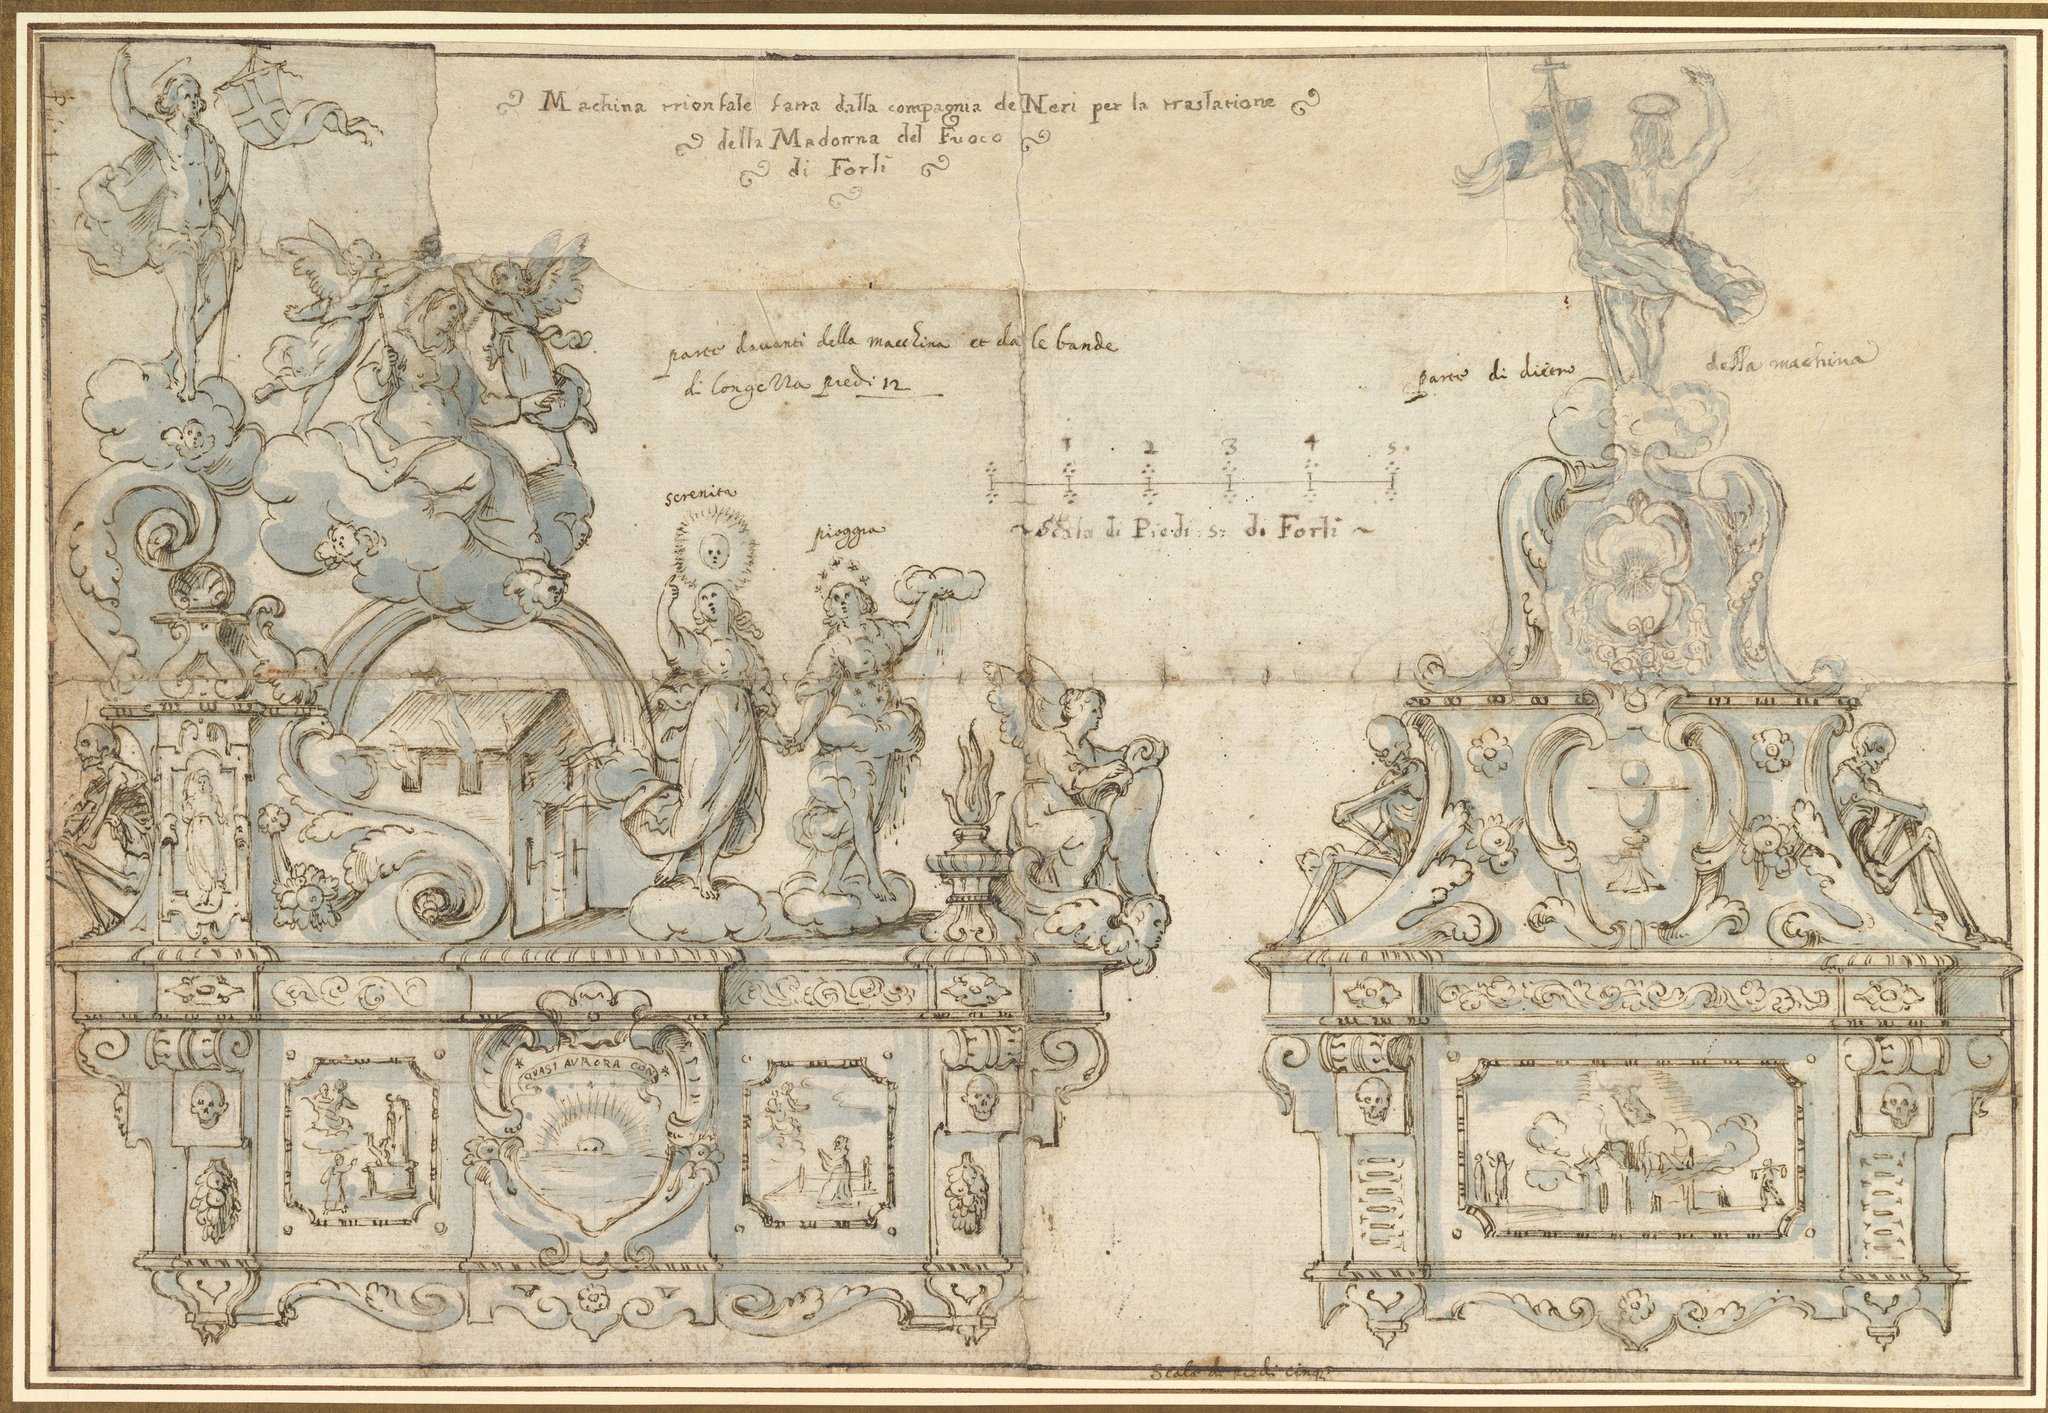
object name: drawing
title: Design for a Processional Float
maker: anonymous, italian, roman-bolognese, 17th century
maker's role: artist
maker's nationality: italian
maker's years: 1600-1700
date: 1601-1700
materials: ink, lead, paper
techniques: brush, pen, wash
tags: skeletons,men,women